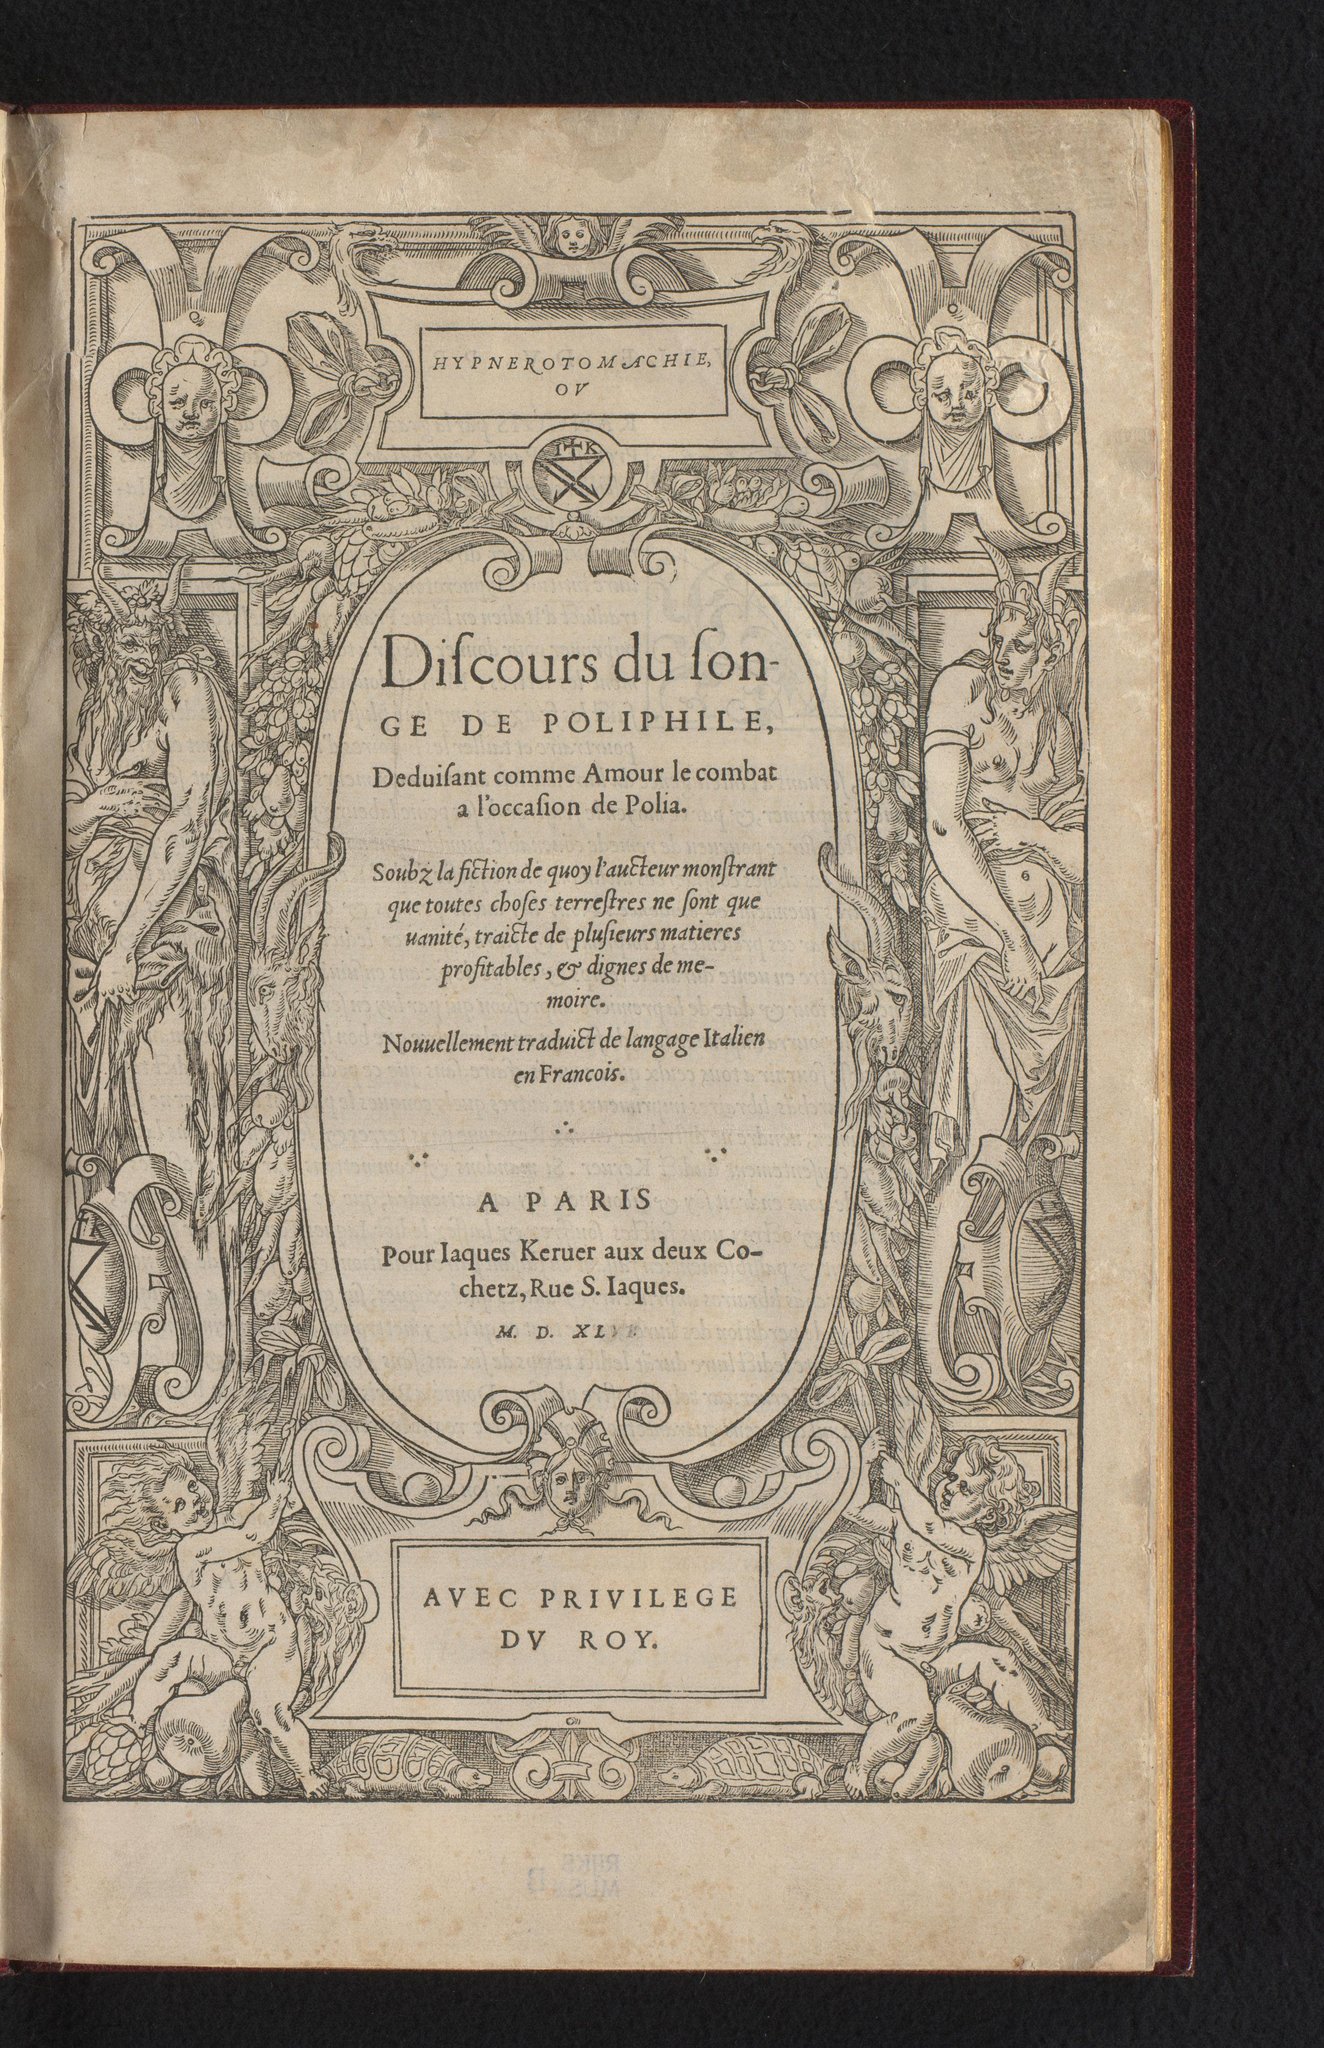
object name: book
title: Songe de Poliphile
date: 1546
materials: cardboard, leather, linen, paper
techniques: bookbinding, printing, letterpress printing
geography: paris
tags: (scenes from) specific works of literature: colonna, hypnerotomachia poliphili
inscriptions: collector's mark: Lugt 2166, collector's mark: Lugt 132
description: Colonna, Francesco. Hypnerotomachie ou discours du songe de Poliphile, deduisant comme amour le combat a l'occasion de Polia. Soubz la fiction de quoy l'aucteur monstrant que toutes choses terrestres ne sont que vanité, traicte de plusieurs matieres profitables, & dignes de memoire. Parijs: Jacques Kerver, 1546. Eerste Franse vertaling van het boek dat origineel in 1499 door Aldus Manutius werd uitgegeven. De illustraties in deze editie zijn deels kopieën naar de houtsnedes in de eerste editie. De band om dit boek is later; laatnegentiende- of vroegtwintigste-eeuws. De cassette lijkt van weer andere datum, gezien de stijlverschillen tussen de (gesigneerde) band en de (ongesigneerde) cassette. Op folium 155 recto is een aantekening in handschrift (inkt) onder de tekst geschreven. Opbouwformule: 2o: a6 A-2B6 2C8. STCN fingerprint: 154602 - a1 *2 e$Pari a2 *3 en$nost - b1 A $a b2 2C4 ny$de$r.